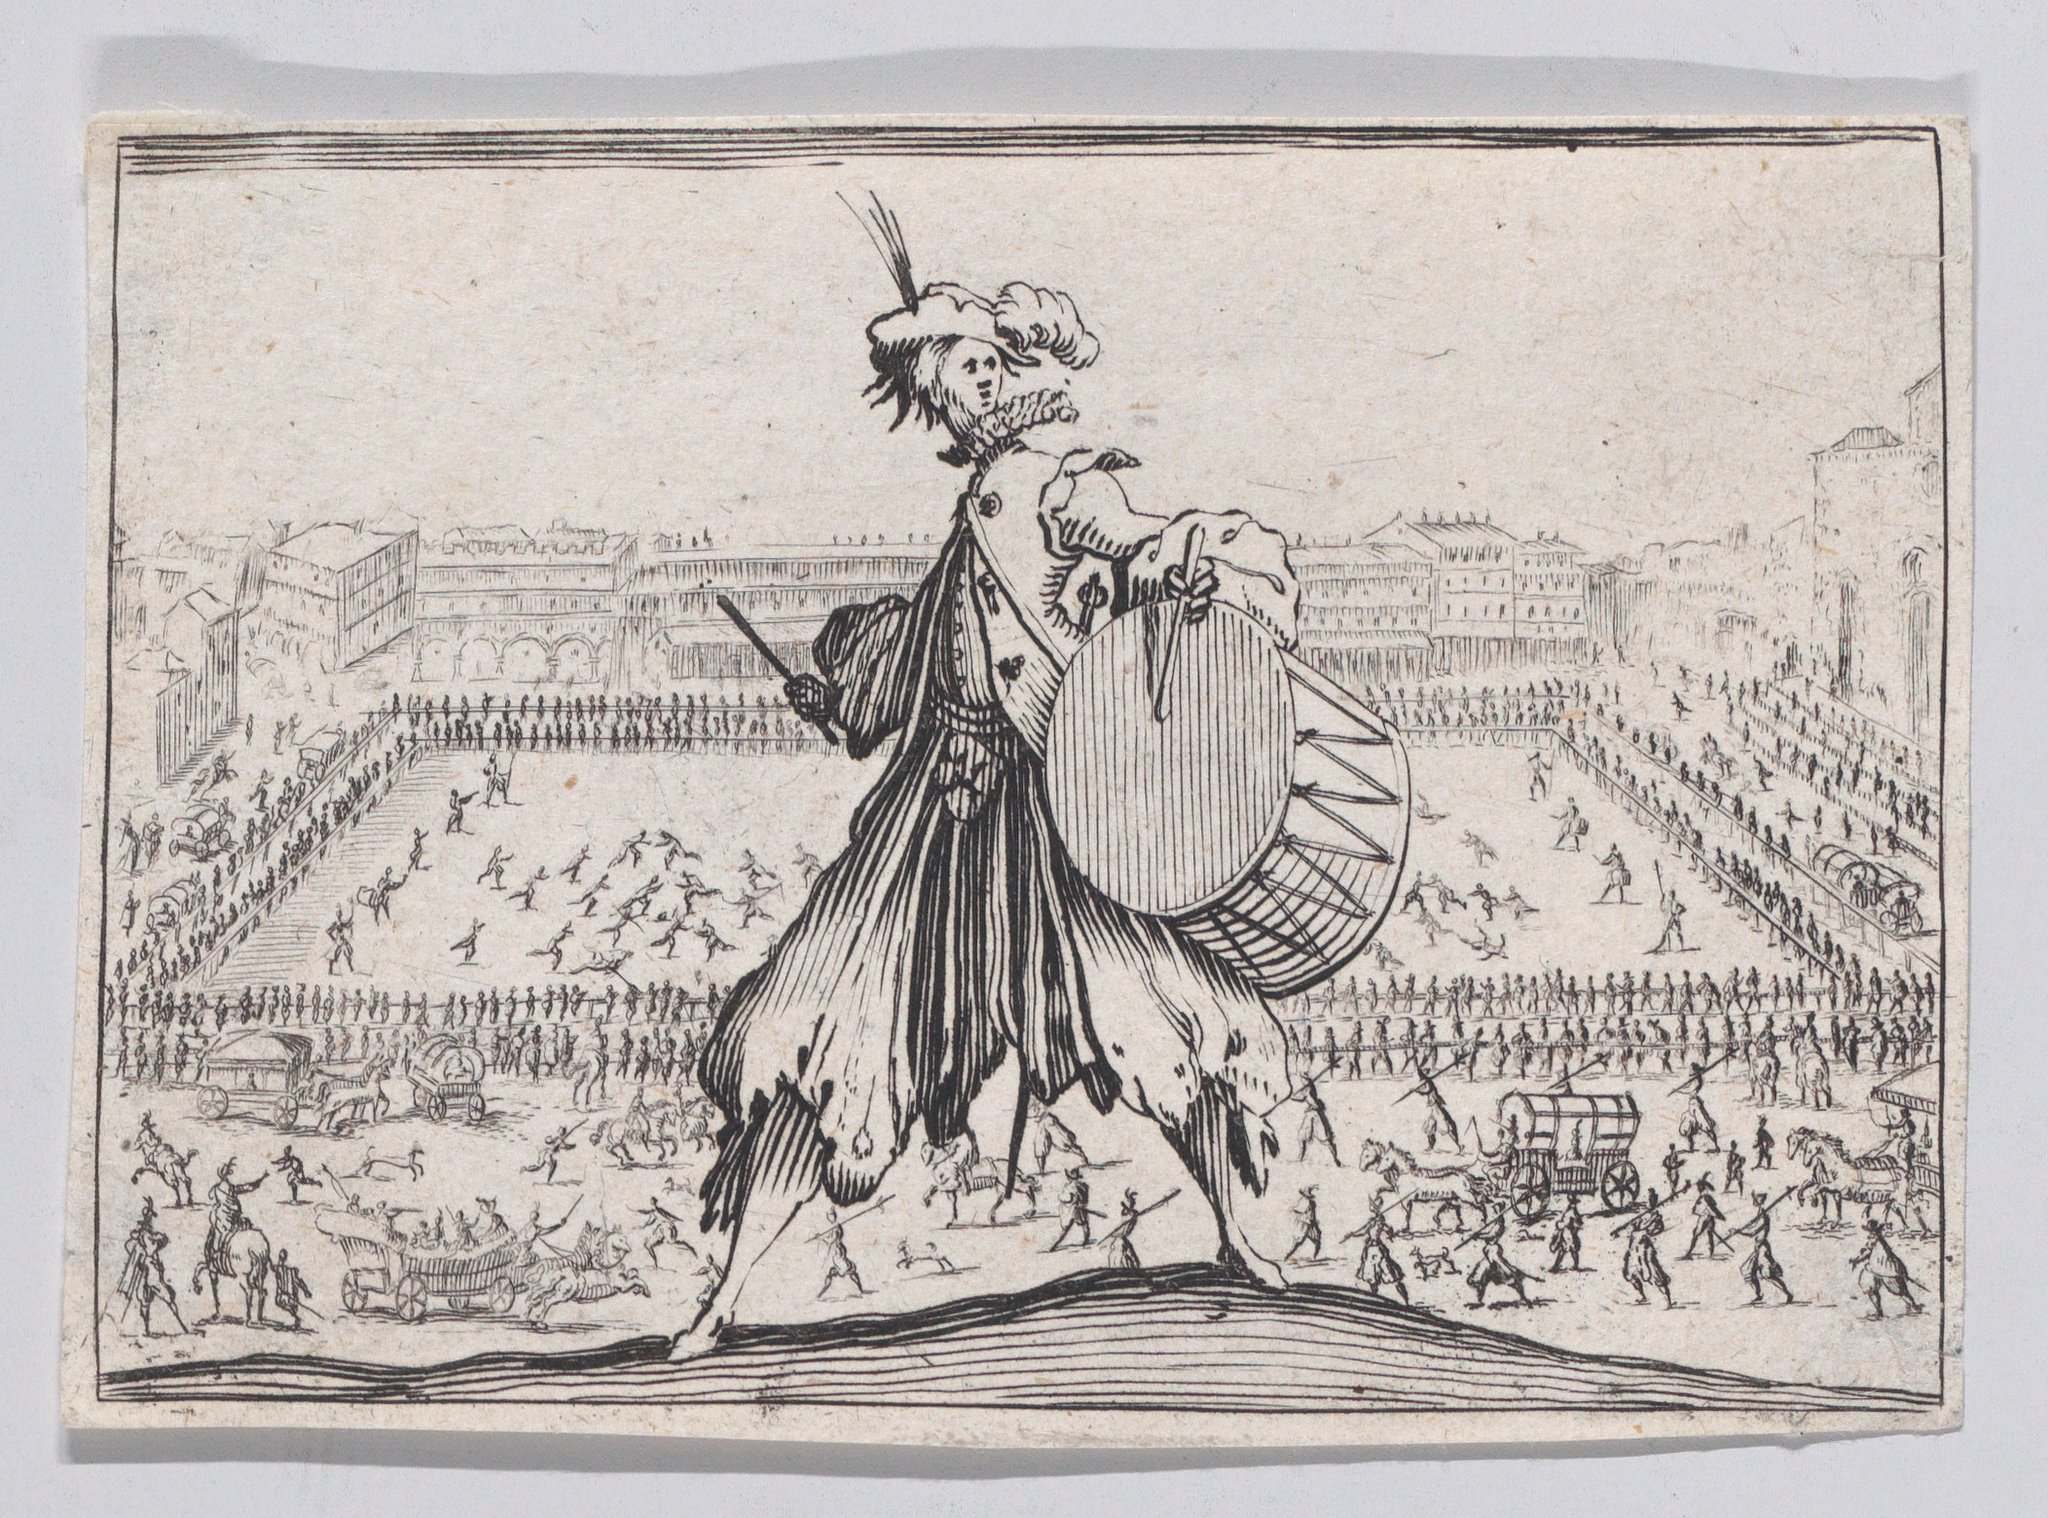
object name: print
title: Copy of Le Jeu de Paume sur la Place Sainte-Croix, a Florence (The Tennis Game at the Piazza Santa Croce, in Florence), from "Les Caprices"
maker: Anonymous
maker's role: artist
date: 1601-1700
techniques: etching